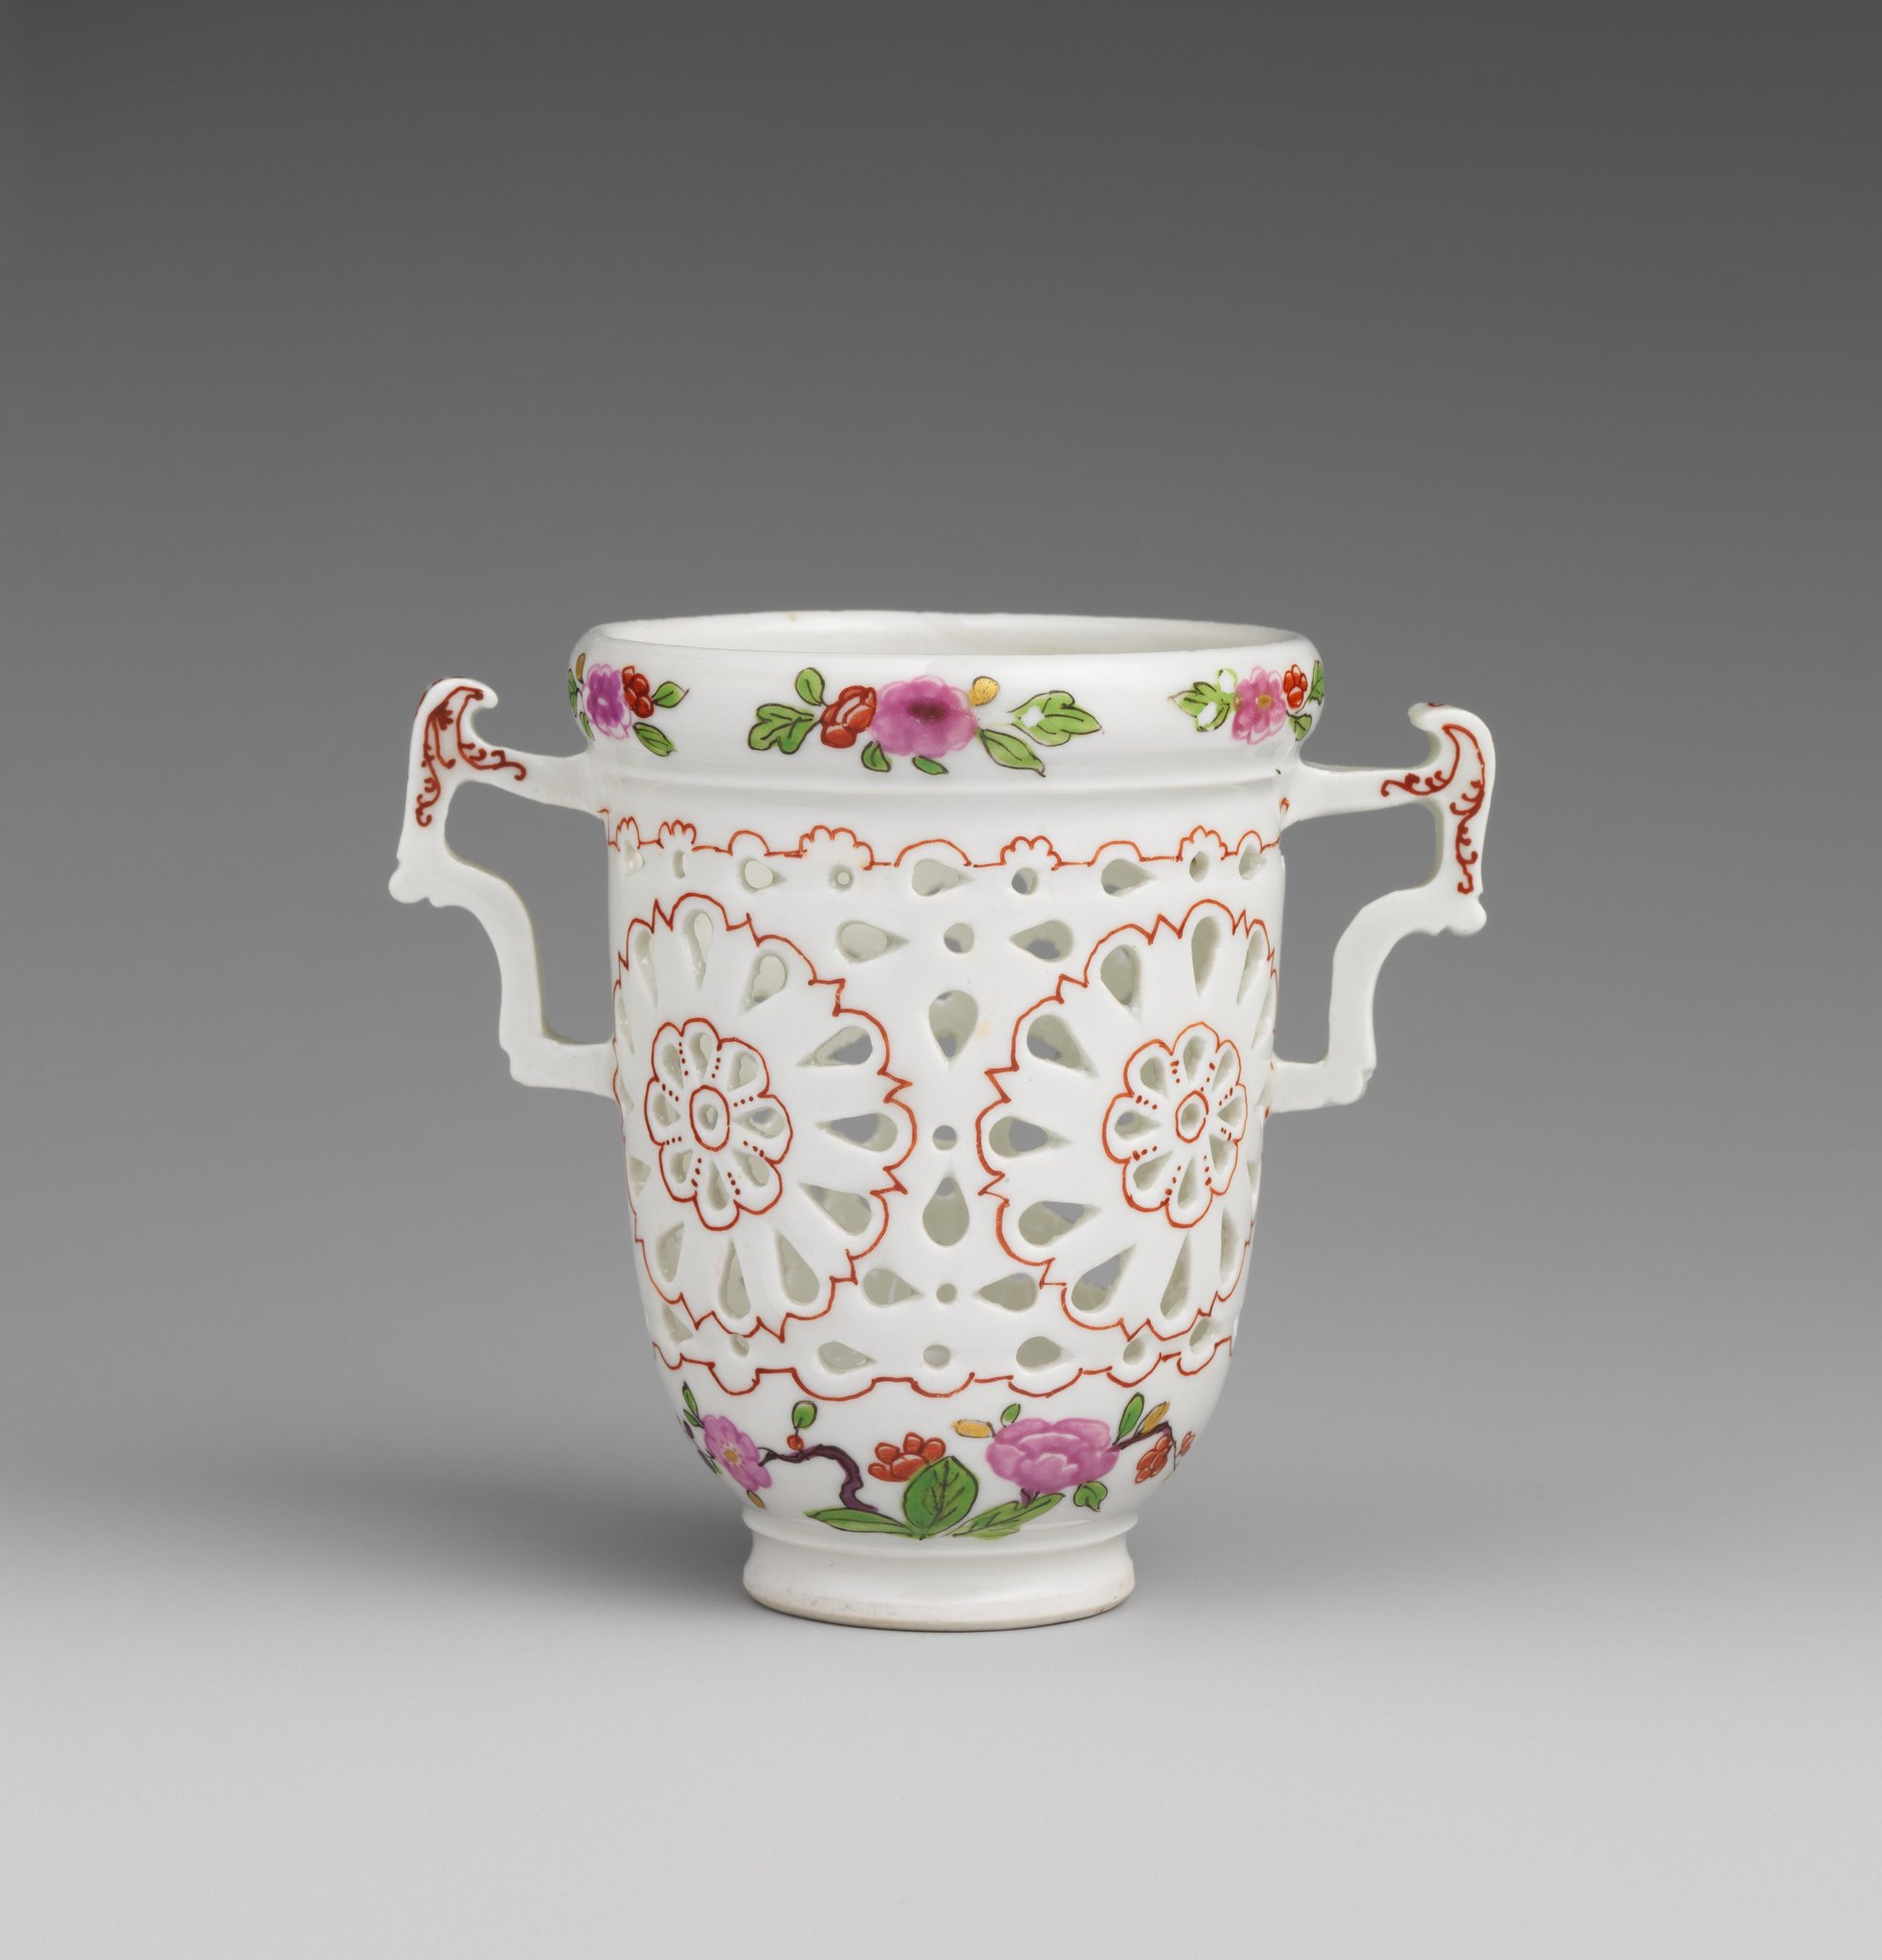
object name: cup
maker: vienna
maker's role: manufactory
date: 1730-1735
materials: hard paste porcelain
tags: flowers